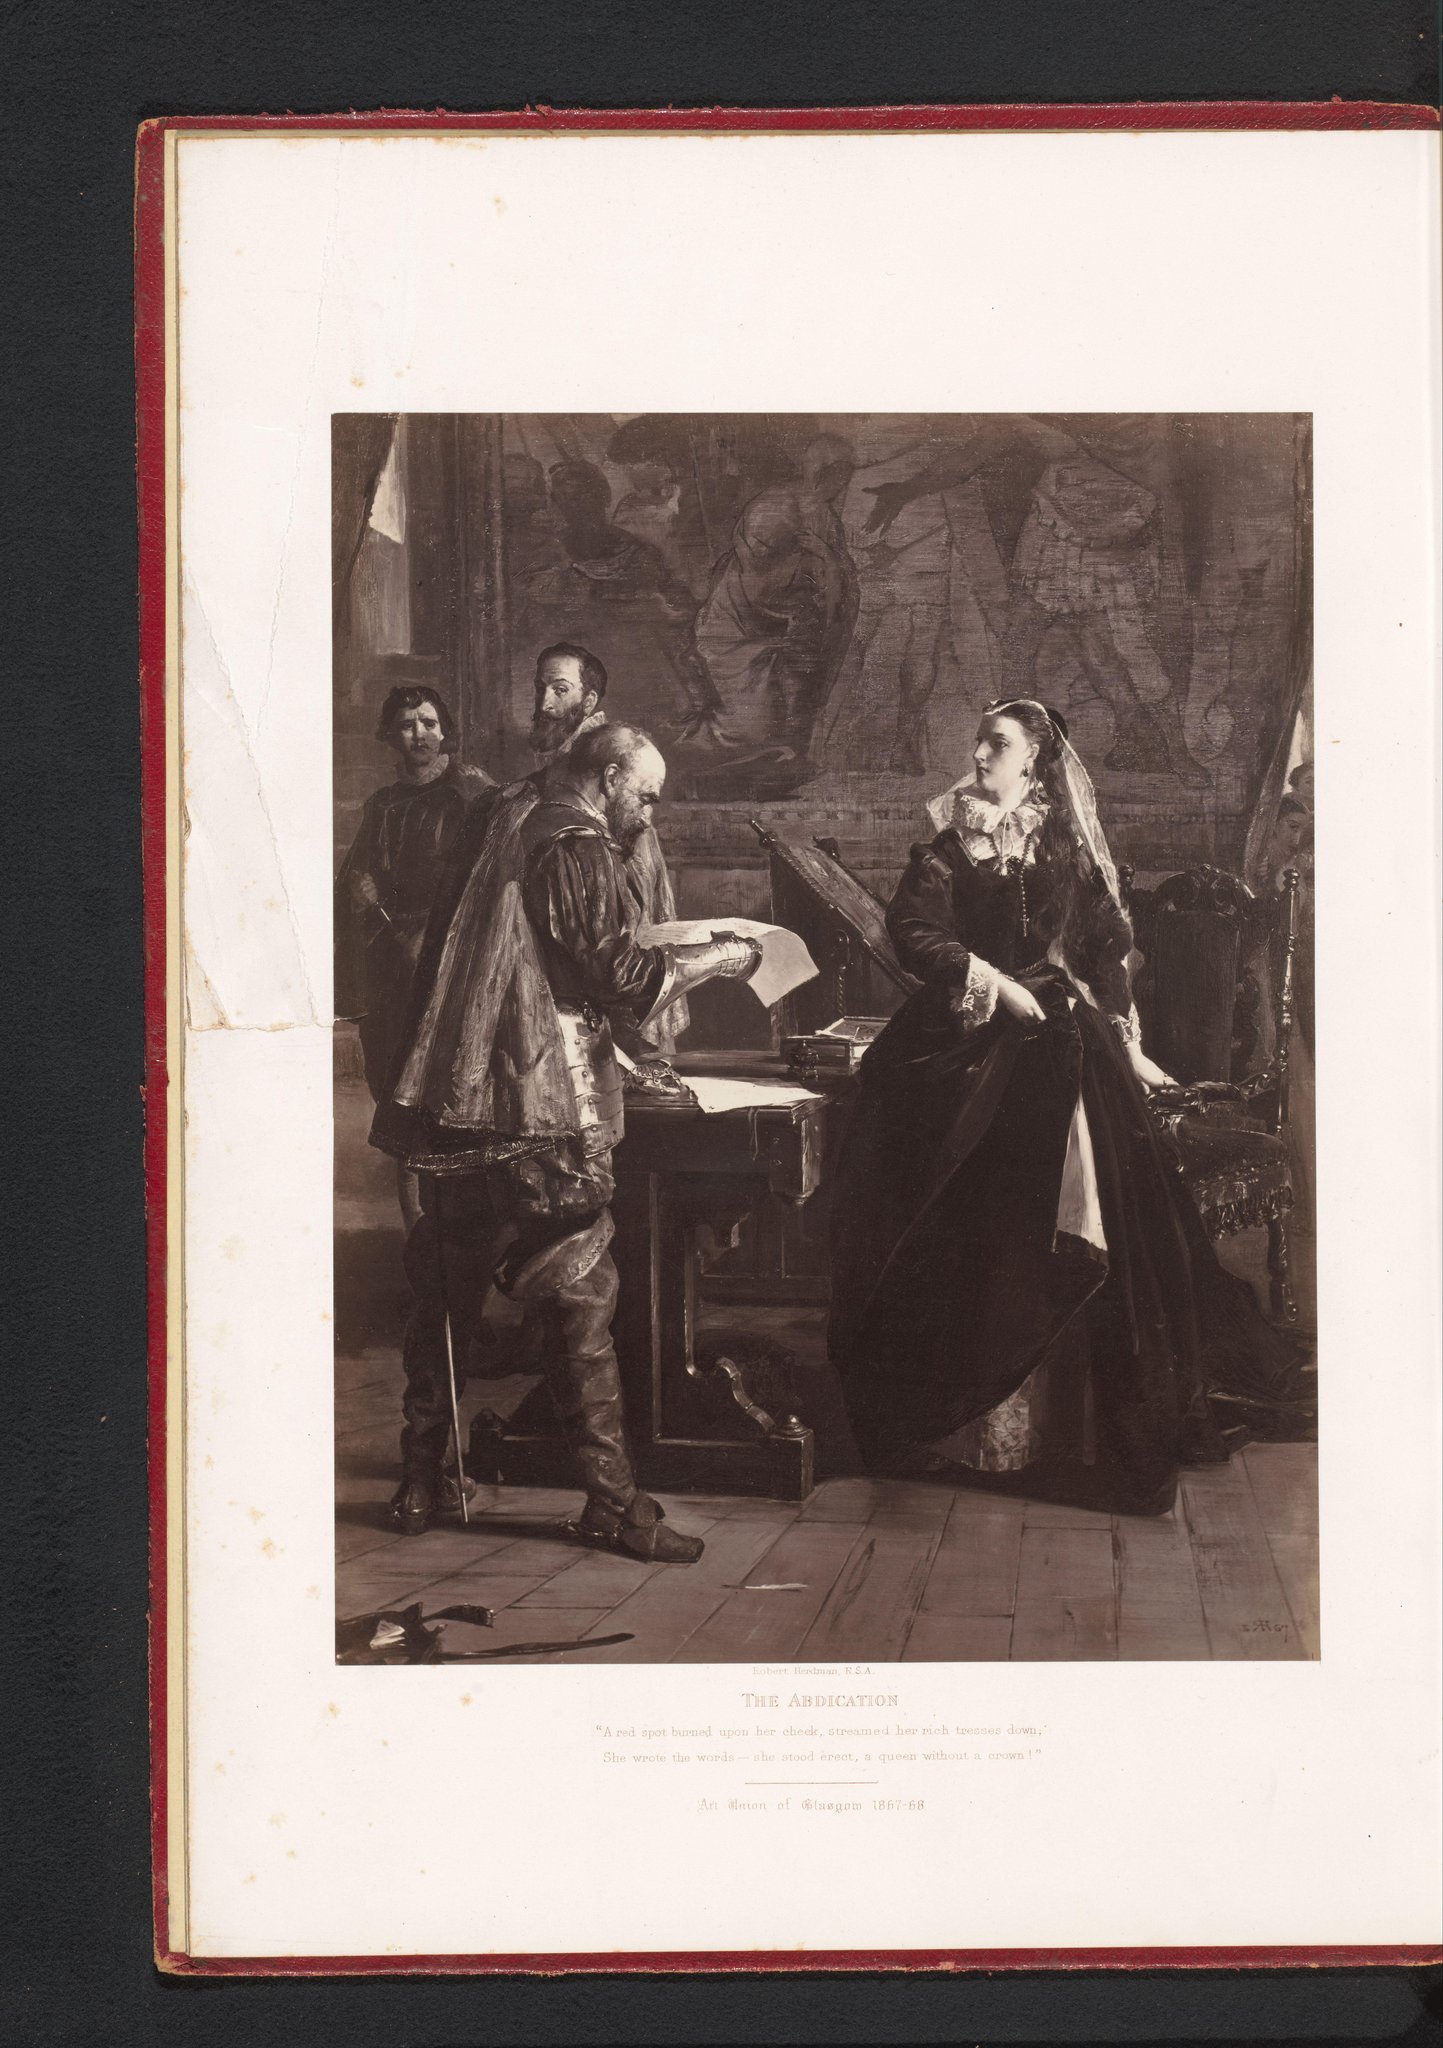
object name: photograph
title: Fotoreproductie van The Abdication door Robert Herdman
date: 1863-1868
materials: paper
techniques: carbon print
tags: abdication (of a ruler) - bb - female ruler, queen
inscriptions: inscription: ‘"A red spot burned upon her cheek, streamed her rich tresses down (...)’